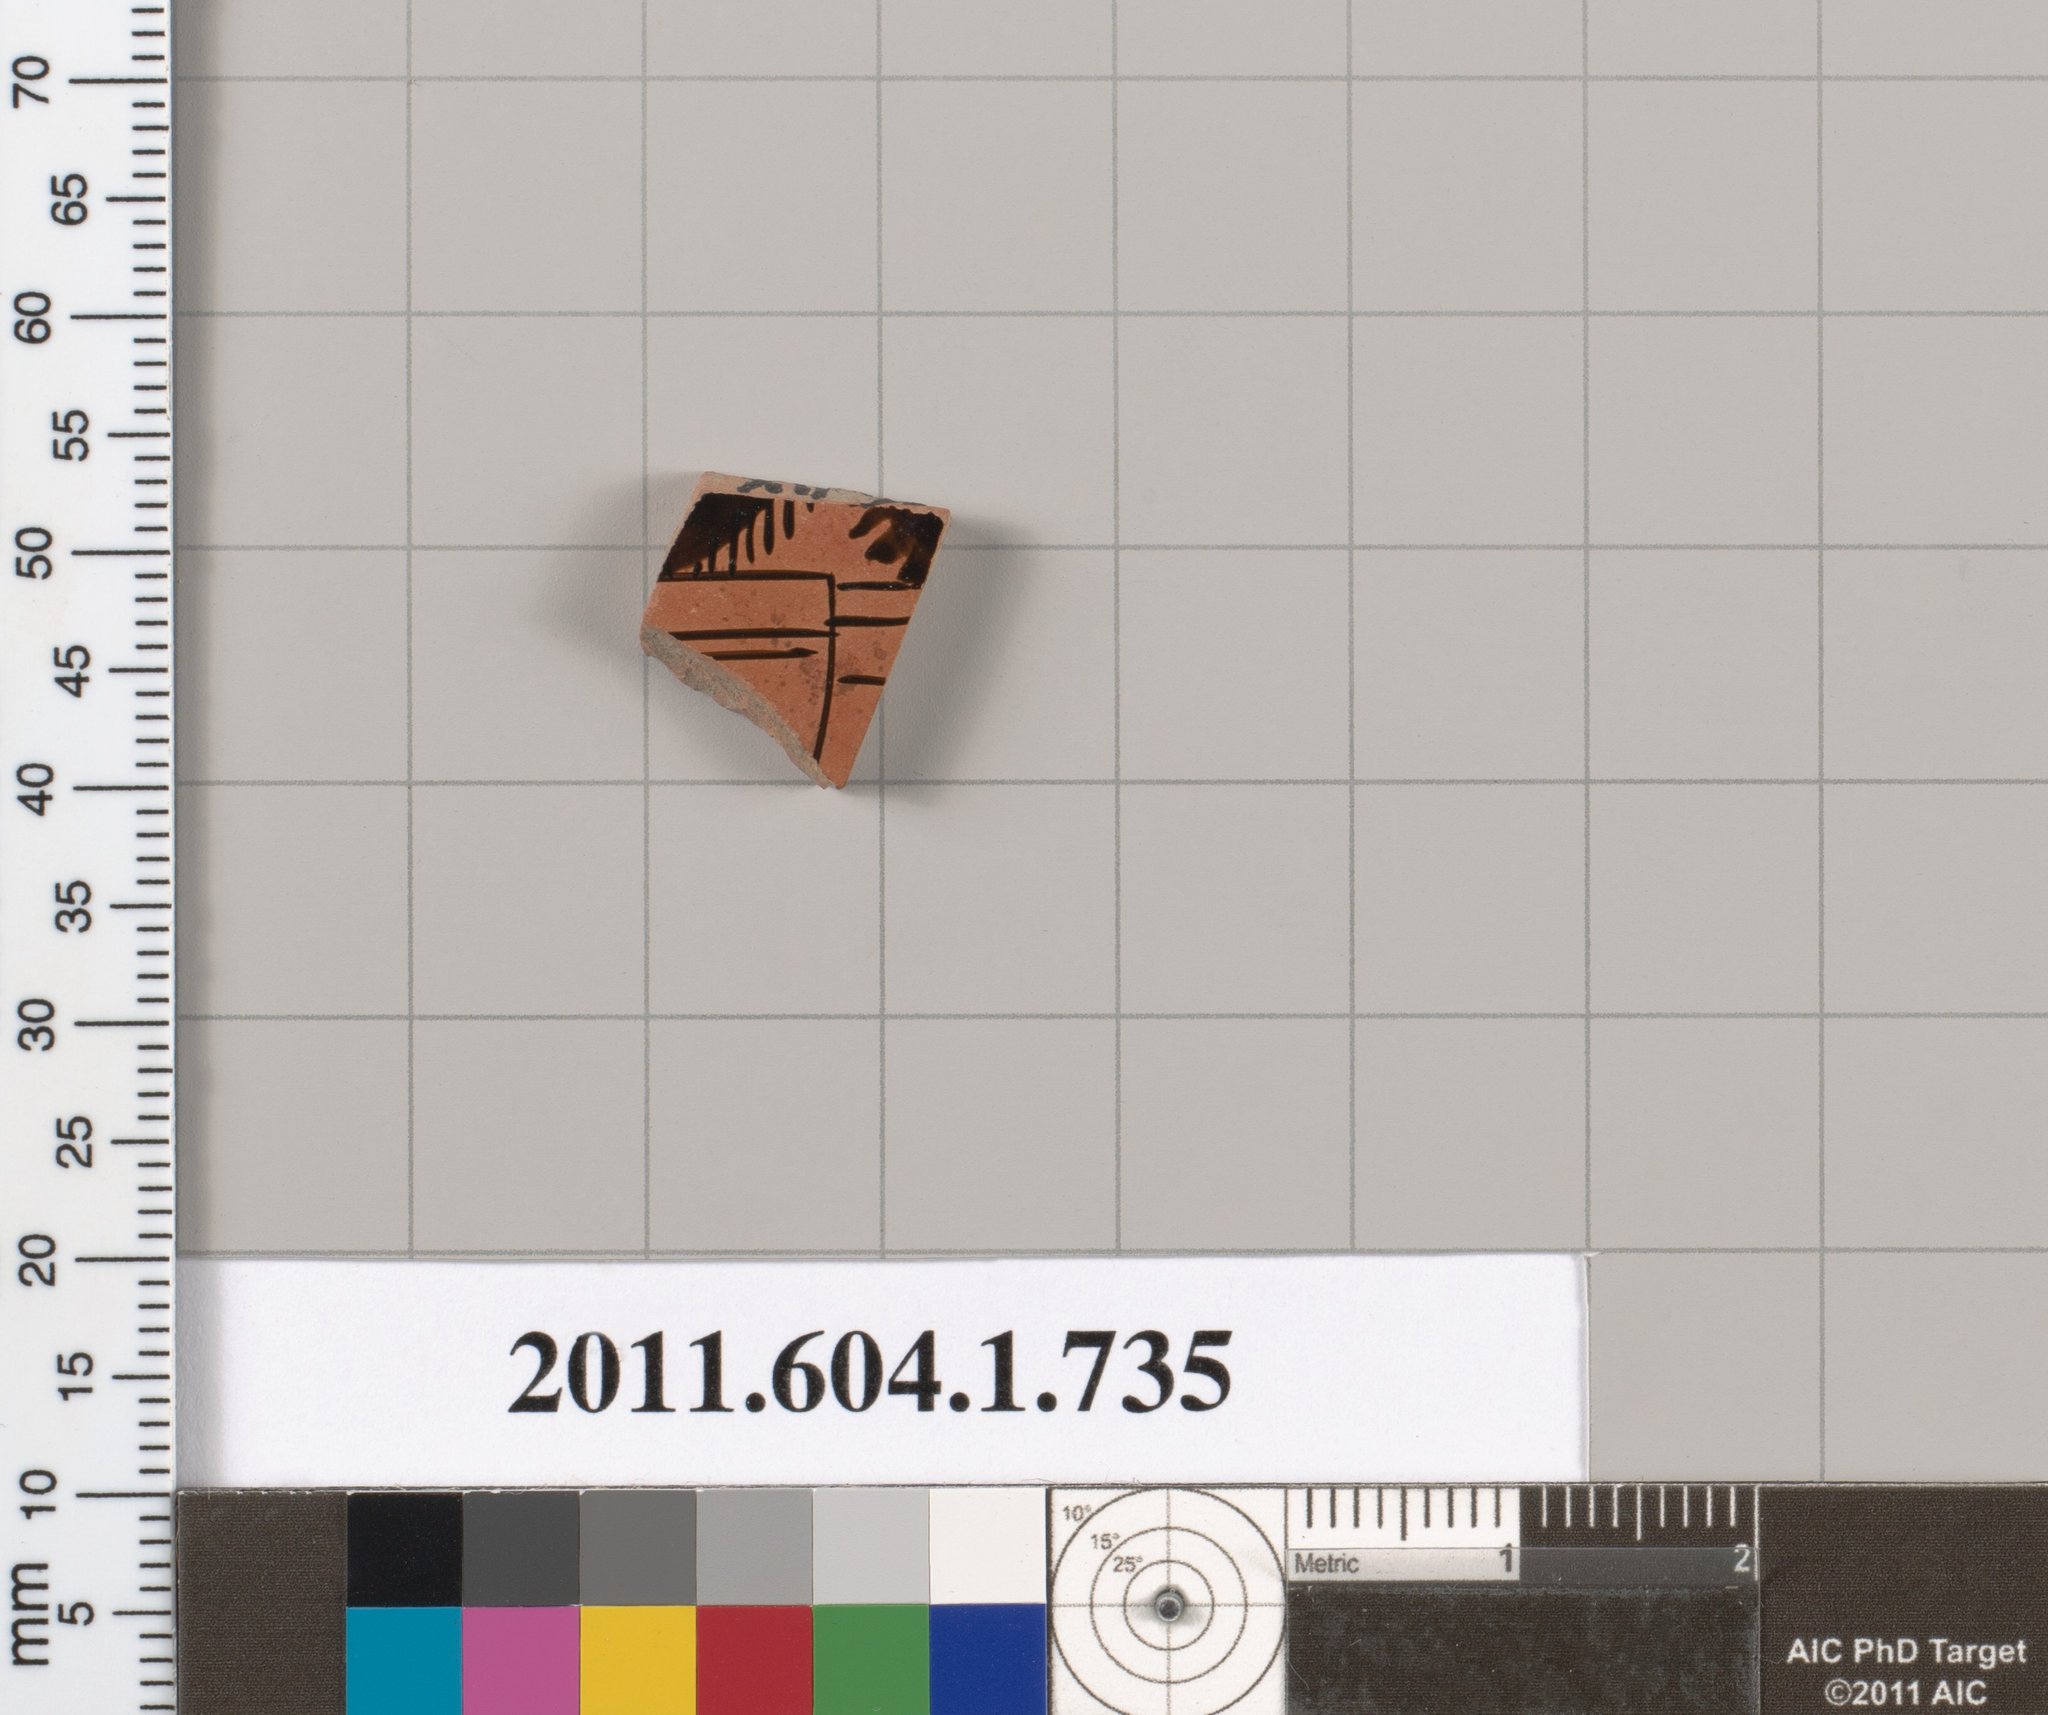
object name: kylix fragment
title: Terracotta fragment of a kylix (drinking cup)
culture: greek, attic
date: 475-451 BCE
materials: terracotta